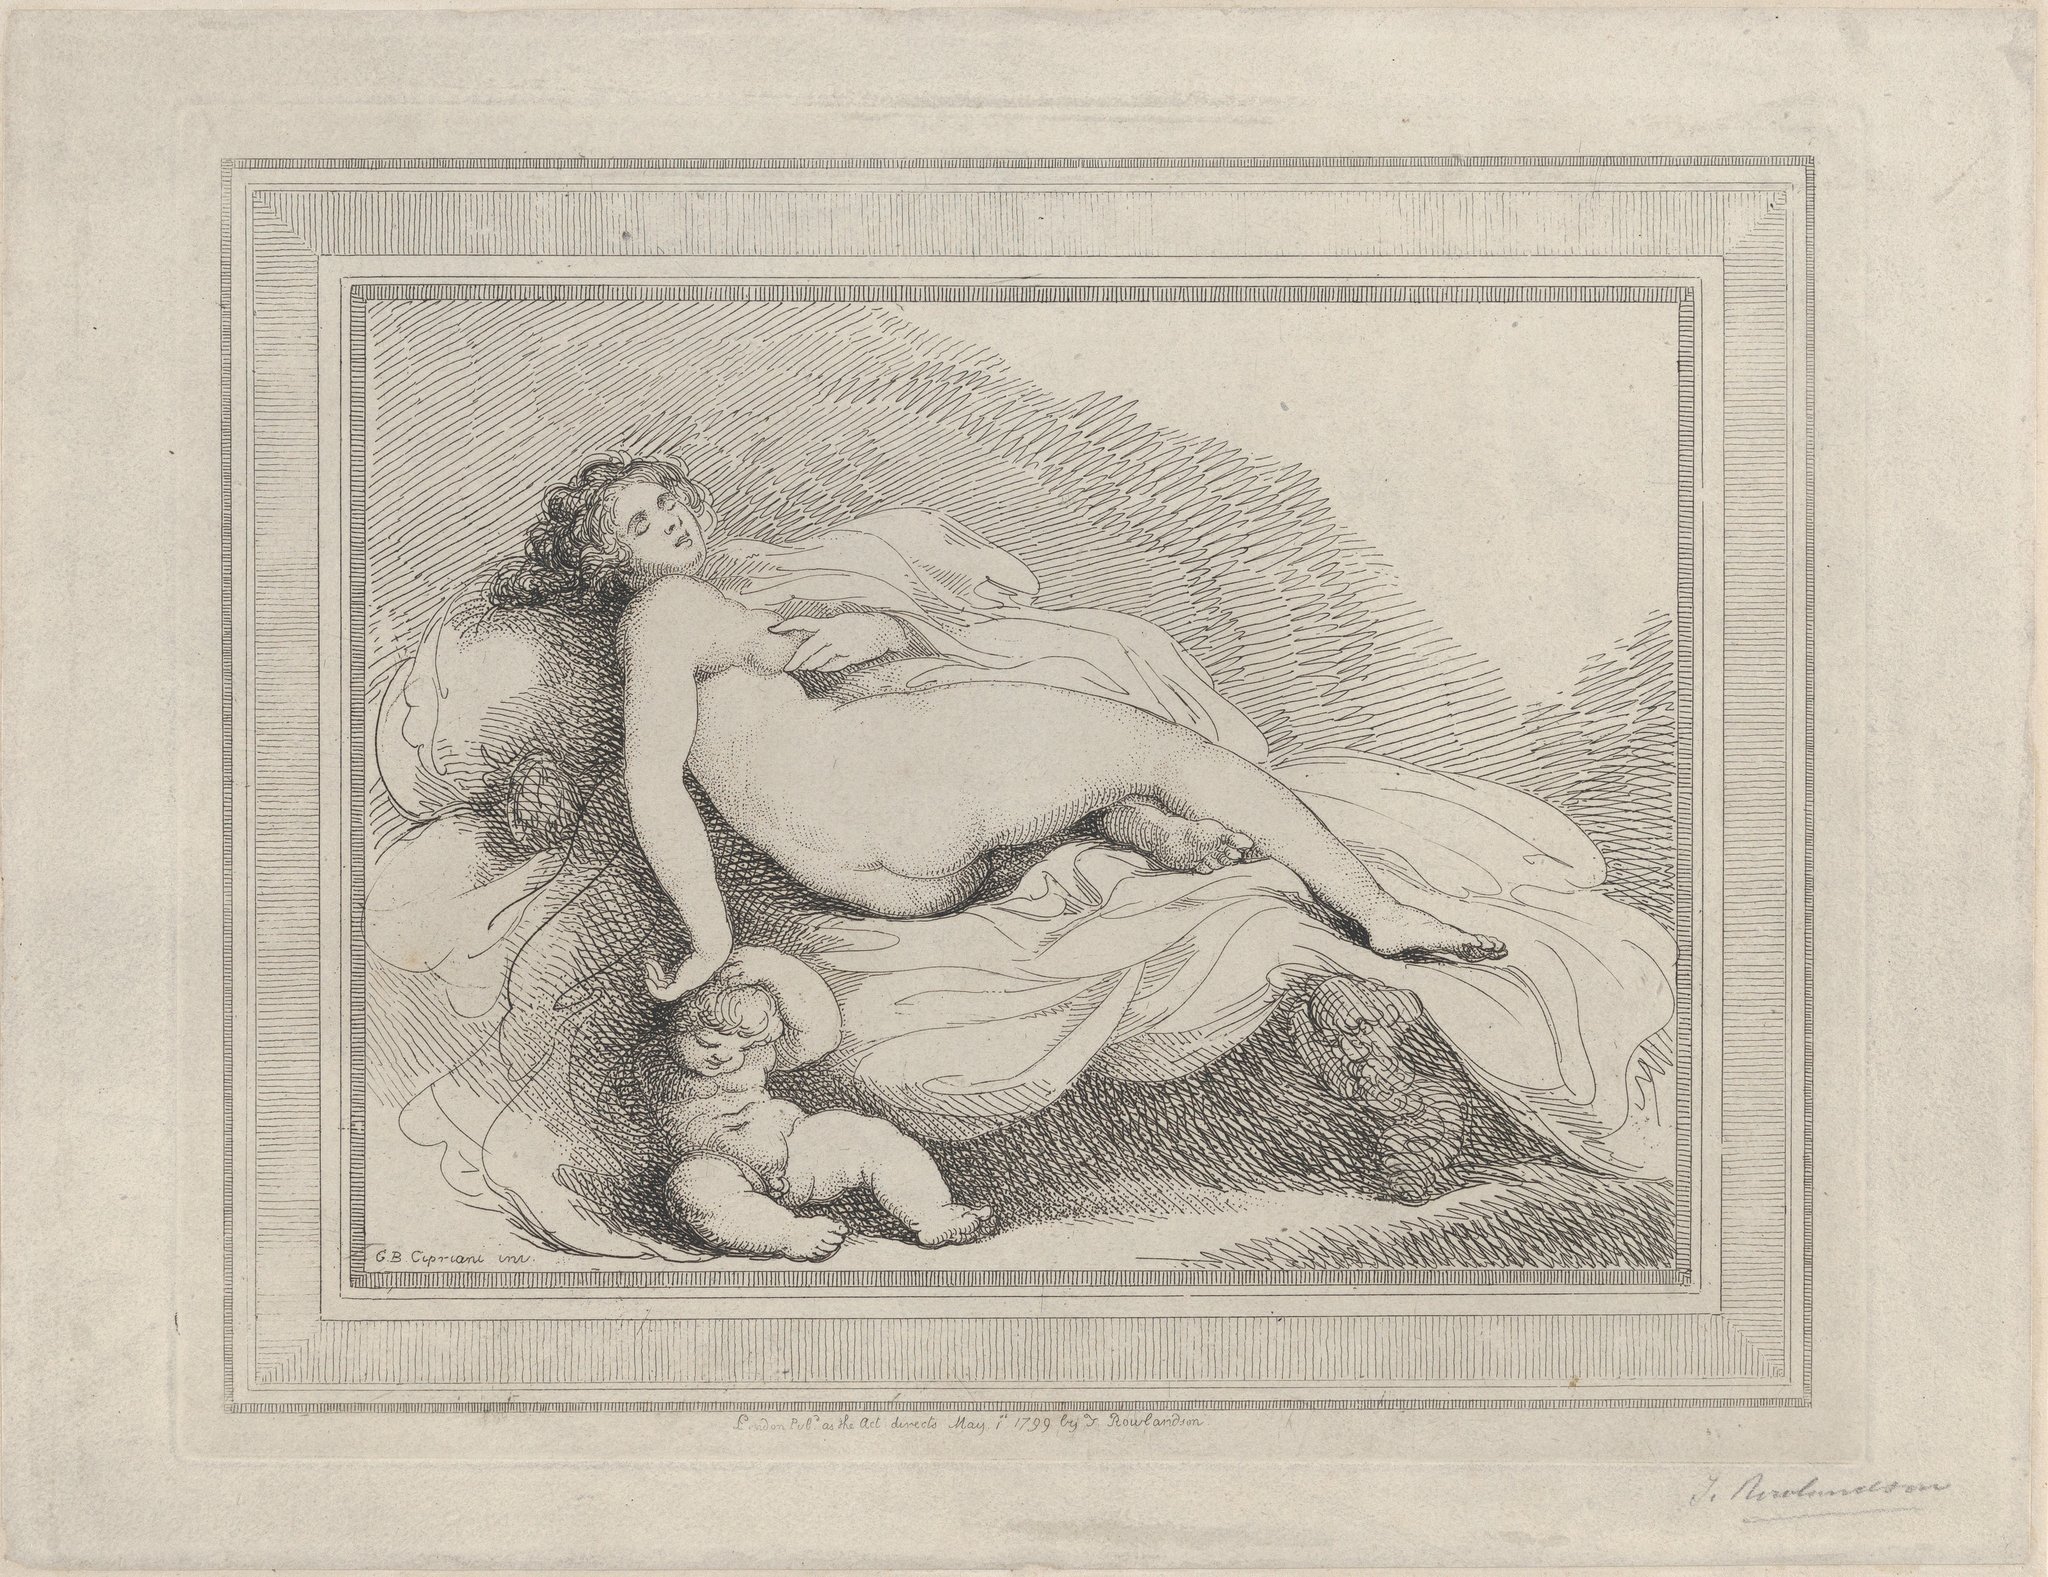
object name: print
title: Sleeping Venus and Love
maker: thomas rowlandson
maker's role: artist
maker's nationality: british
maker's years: 1757-1827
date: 1799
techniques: etching, stippling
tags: sleeping,boys,female nudes